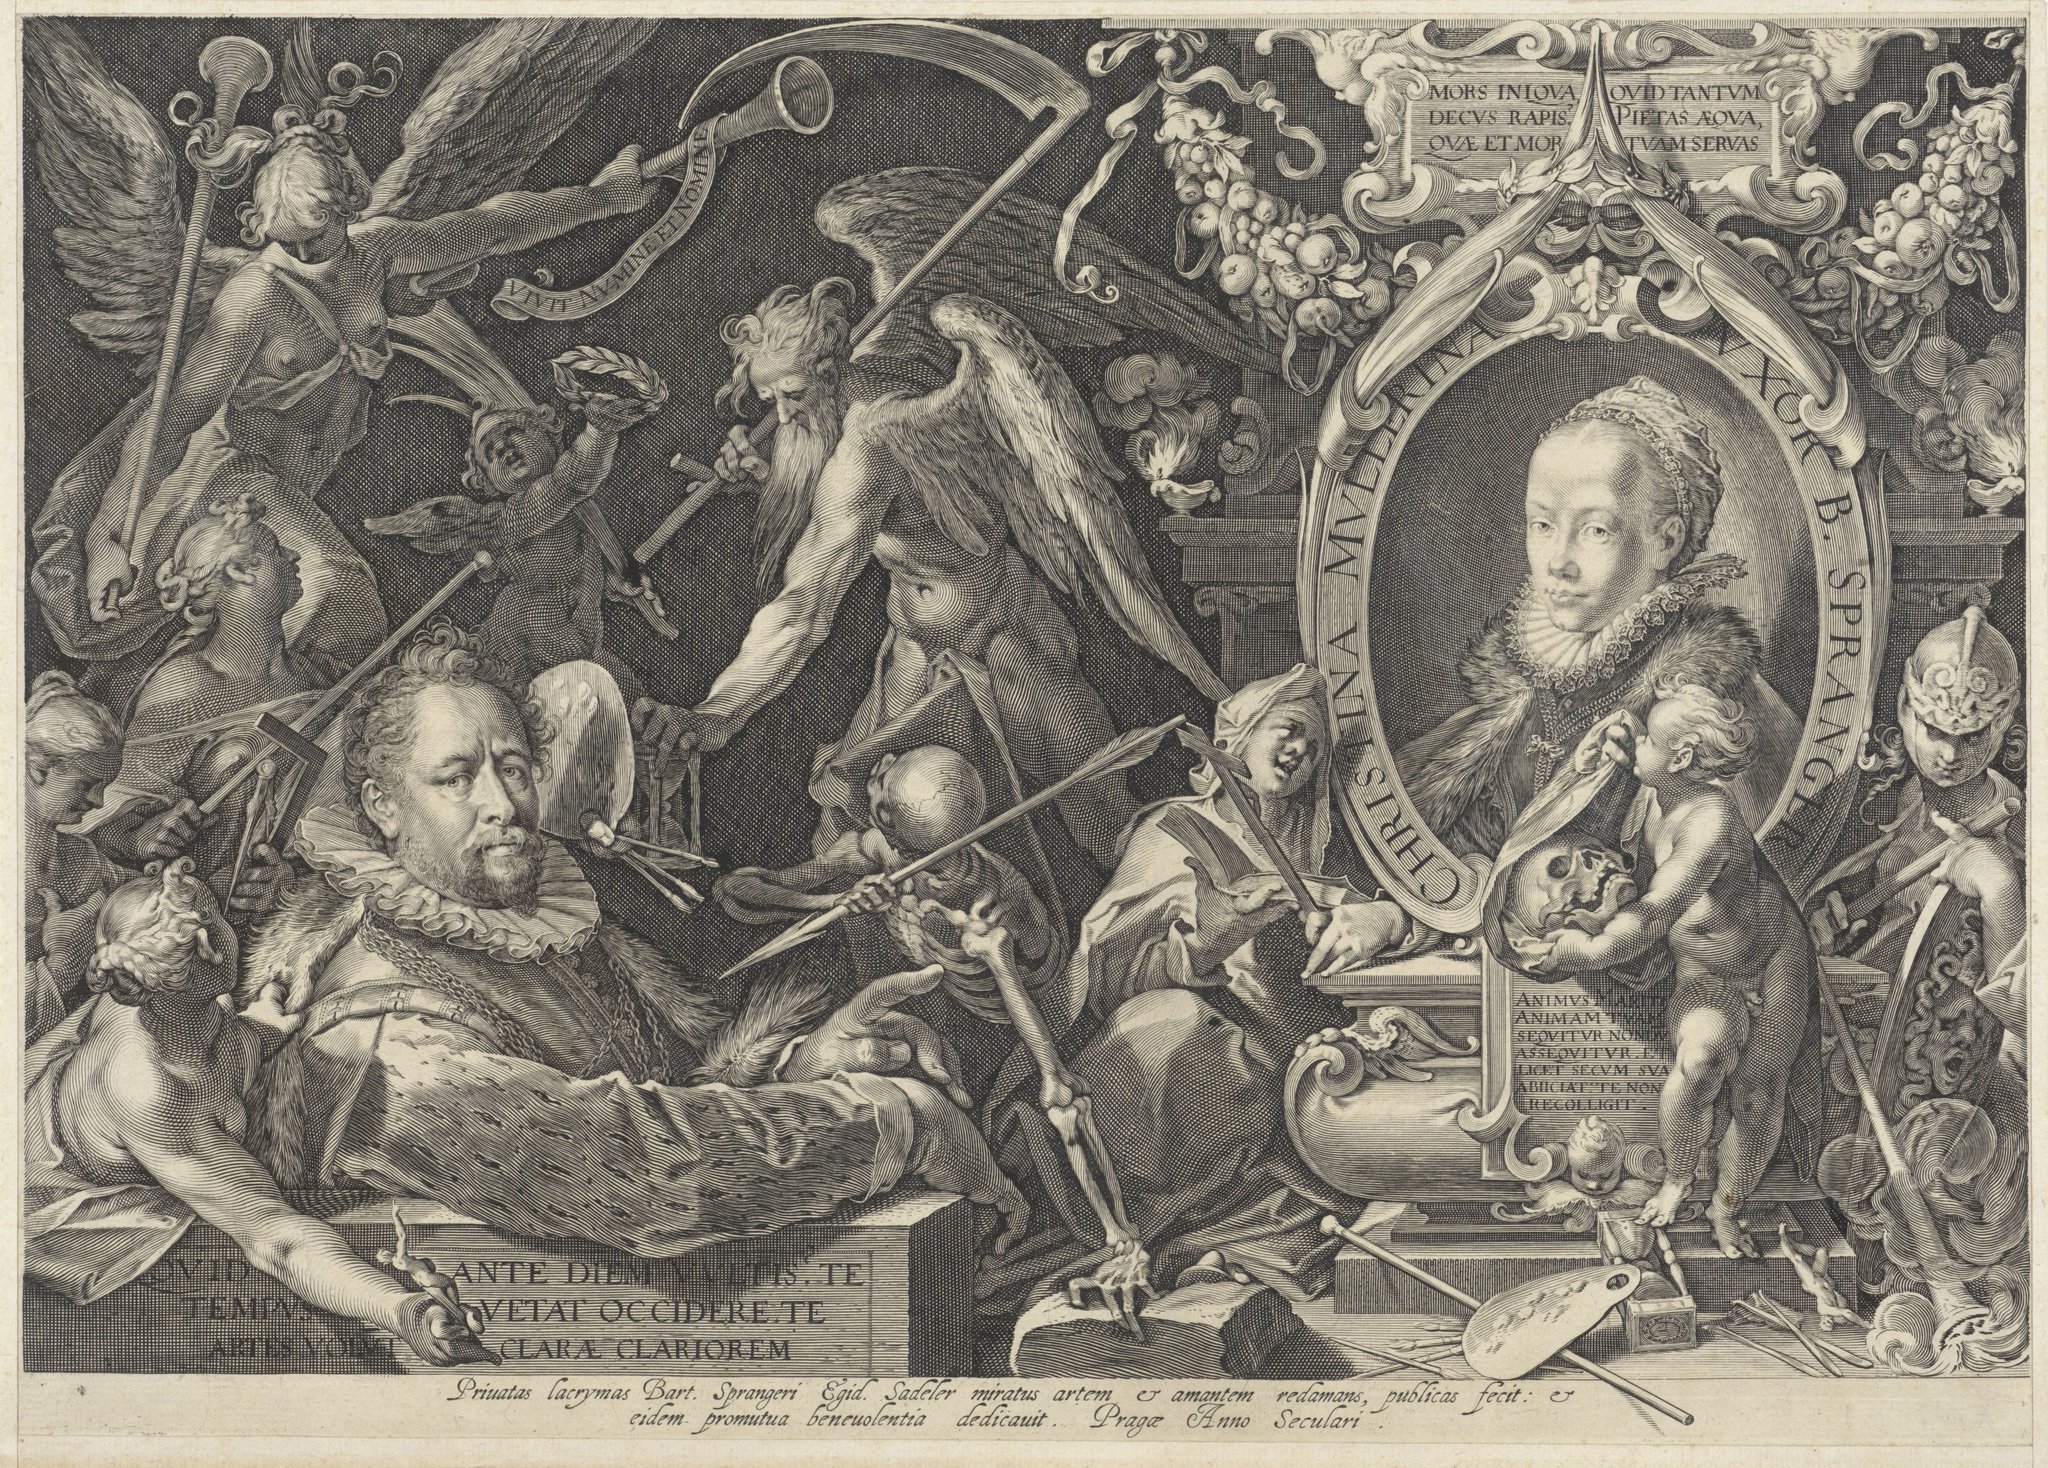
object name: print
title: Allegorisch portret van Bartholomeus Spranger en zijn vrouw Christina Muller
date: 1600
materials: paper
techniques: engraving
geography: prague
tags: antwerp, prague, print maker, draughtsman, bartholomeus spranger, faith, 'fides'; 'fede', 'fede catholica', 'fede christiana', 'fede christiana catholica' (ripa) ~ one of the three theological virtues, (story of) minerva (pallas, athena), death as skeleton, tools, implements of painter, fame; 'fama', 'fama buona', 'fama chiara' (ripa), ornament ~ festoon, garland, father time, man with wings and scythe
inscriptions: collector's mark: Lugt 700a, collector's mark: Lugt 2228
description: Gedenkprent voor de overleden vrouw van de schilder Batholomeus Spranger. Links Bartholomeus Spranger en rechts zijn vrouw Christina Muller. De twee portretten worden omringd door de personificaties van de vrije kunsten, het geloof, de tijd, de dood en de roem.